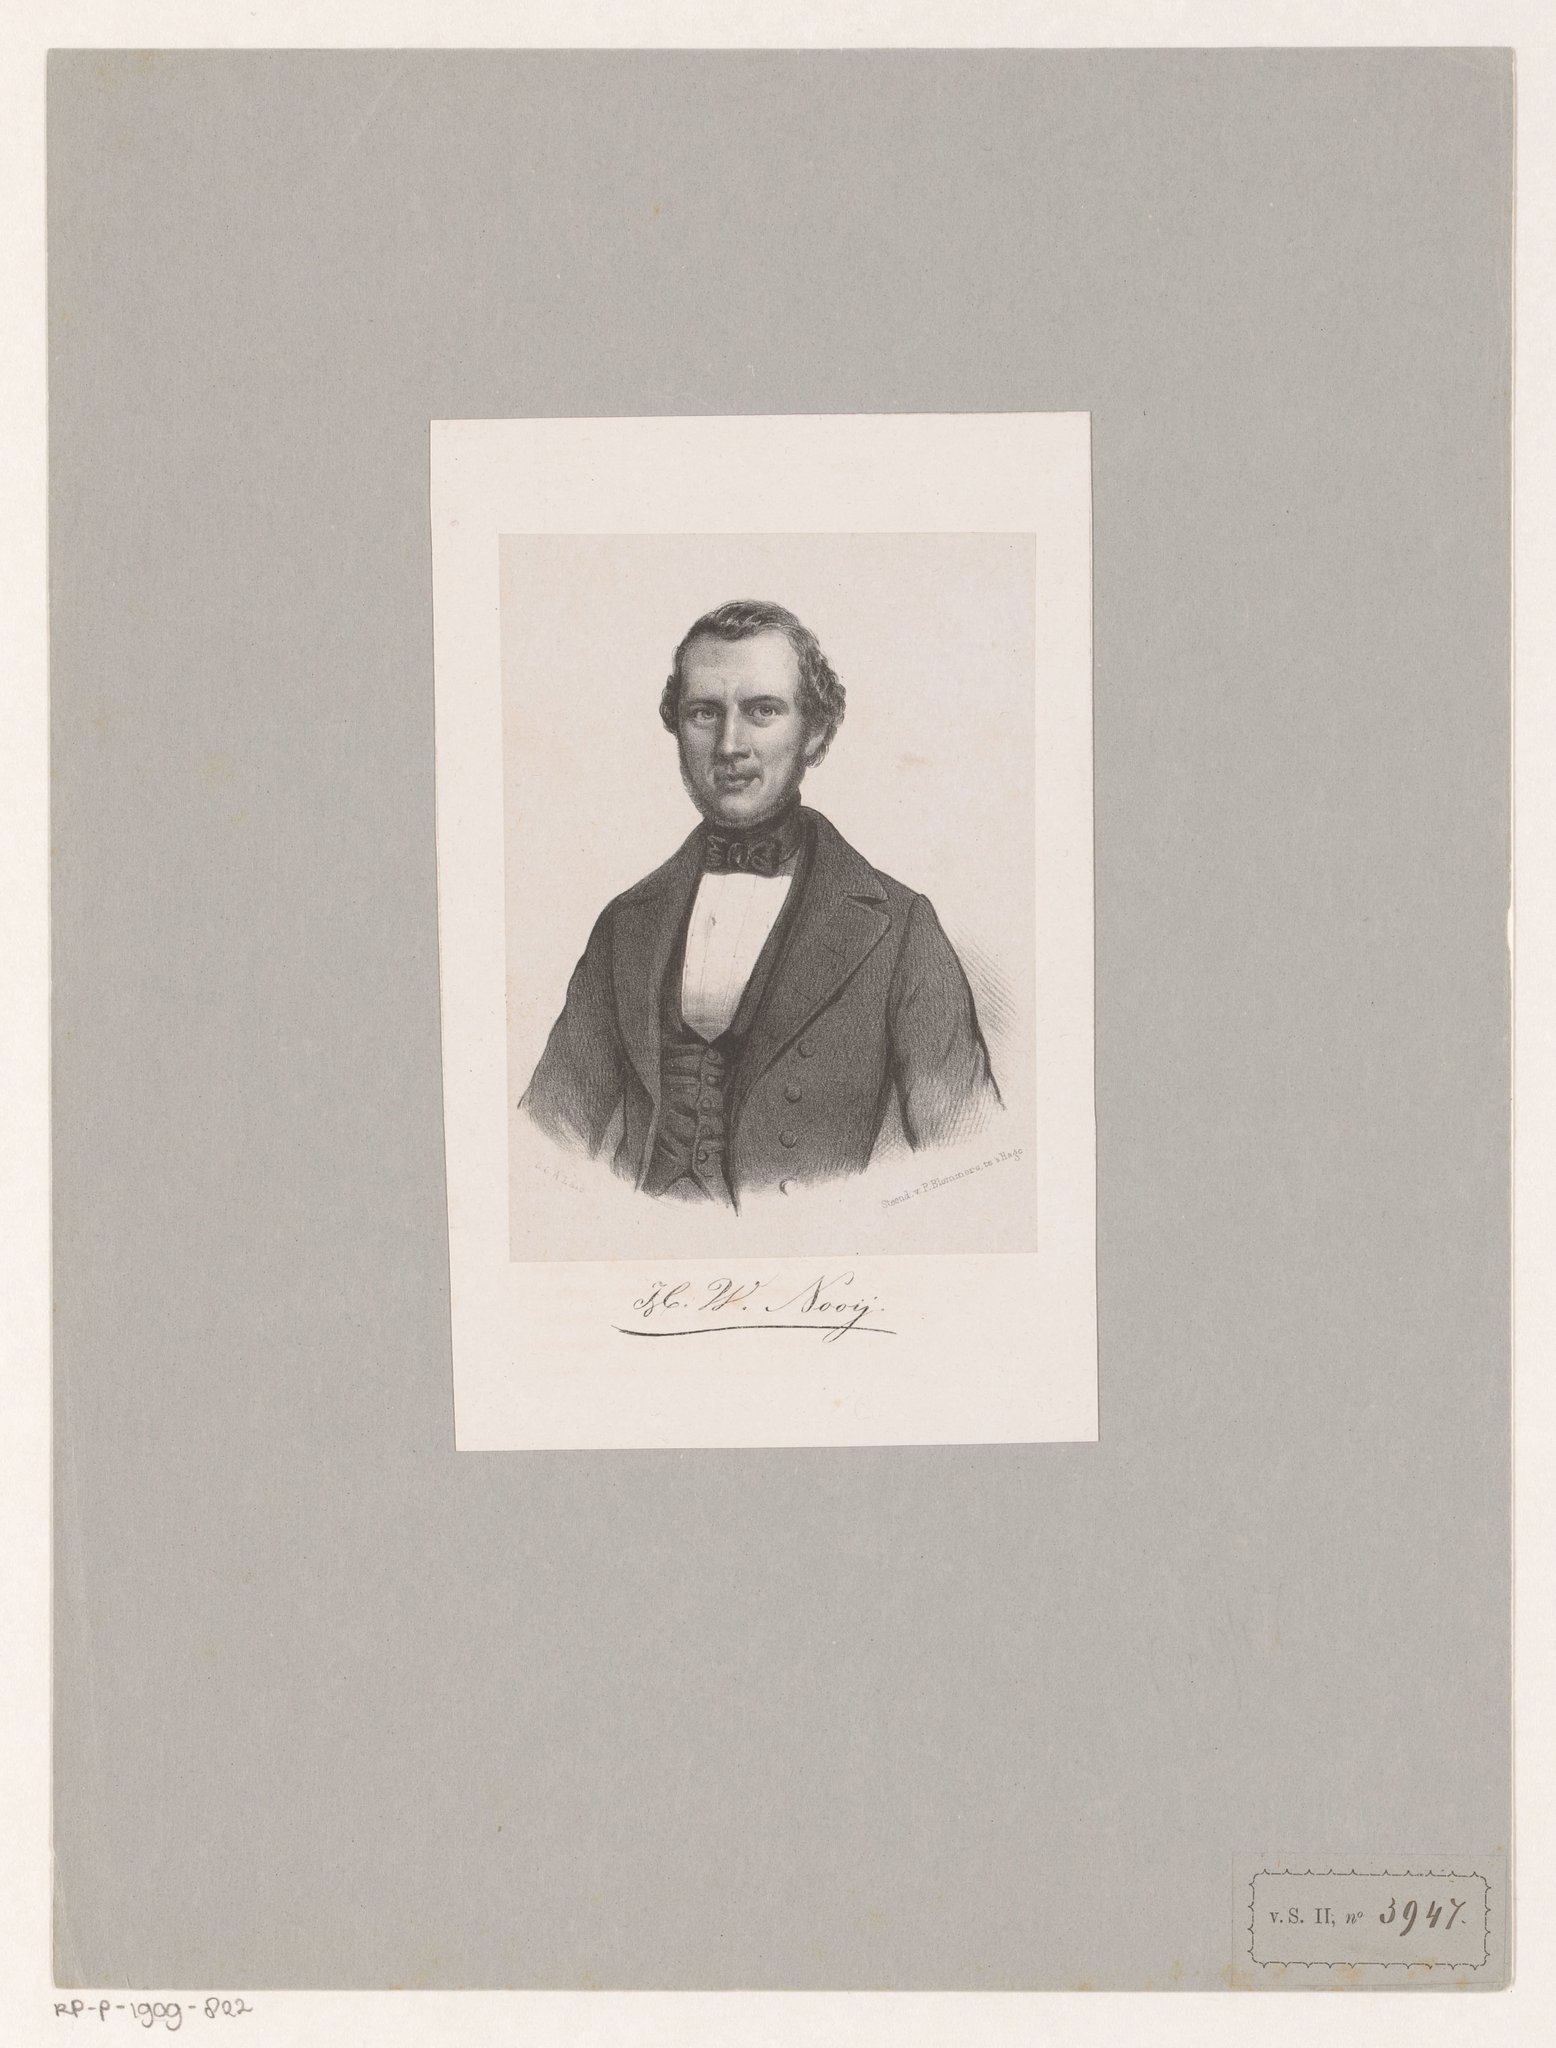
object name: print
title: Portret van H.W. Nooy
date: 1858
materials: paper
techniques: lithograph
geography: netherlands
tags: historical persons (+ (full) bust portrait)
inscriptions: collector's mark: Lugt 2228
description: Onder het portret de signatuur van de geportretteerde.